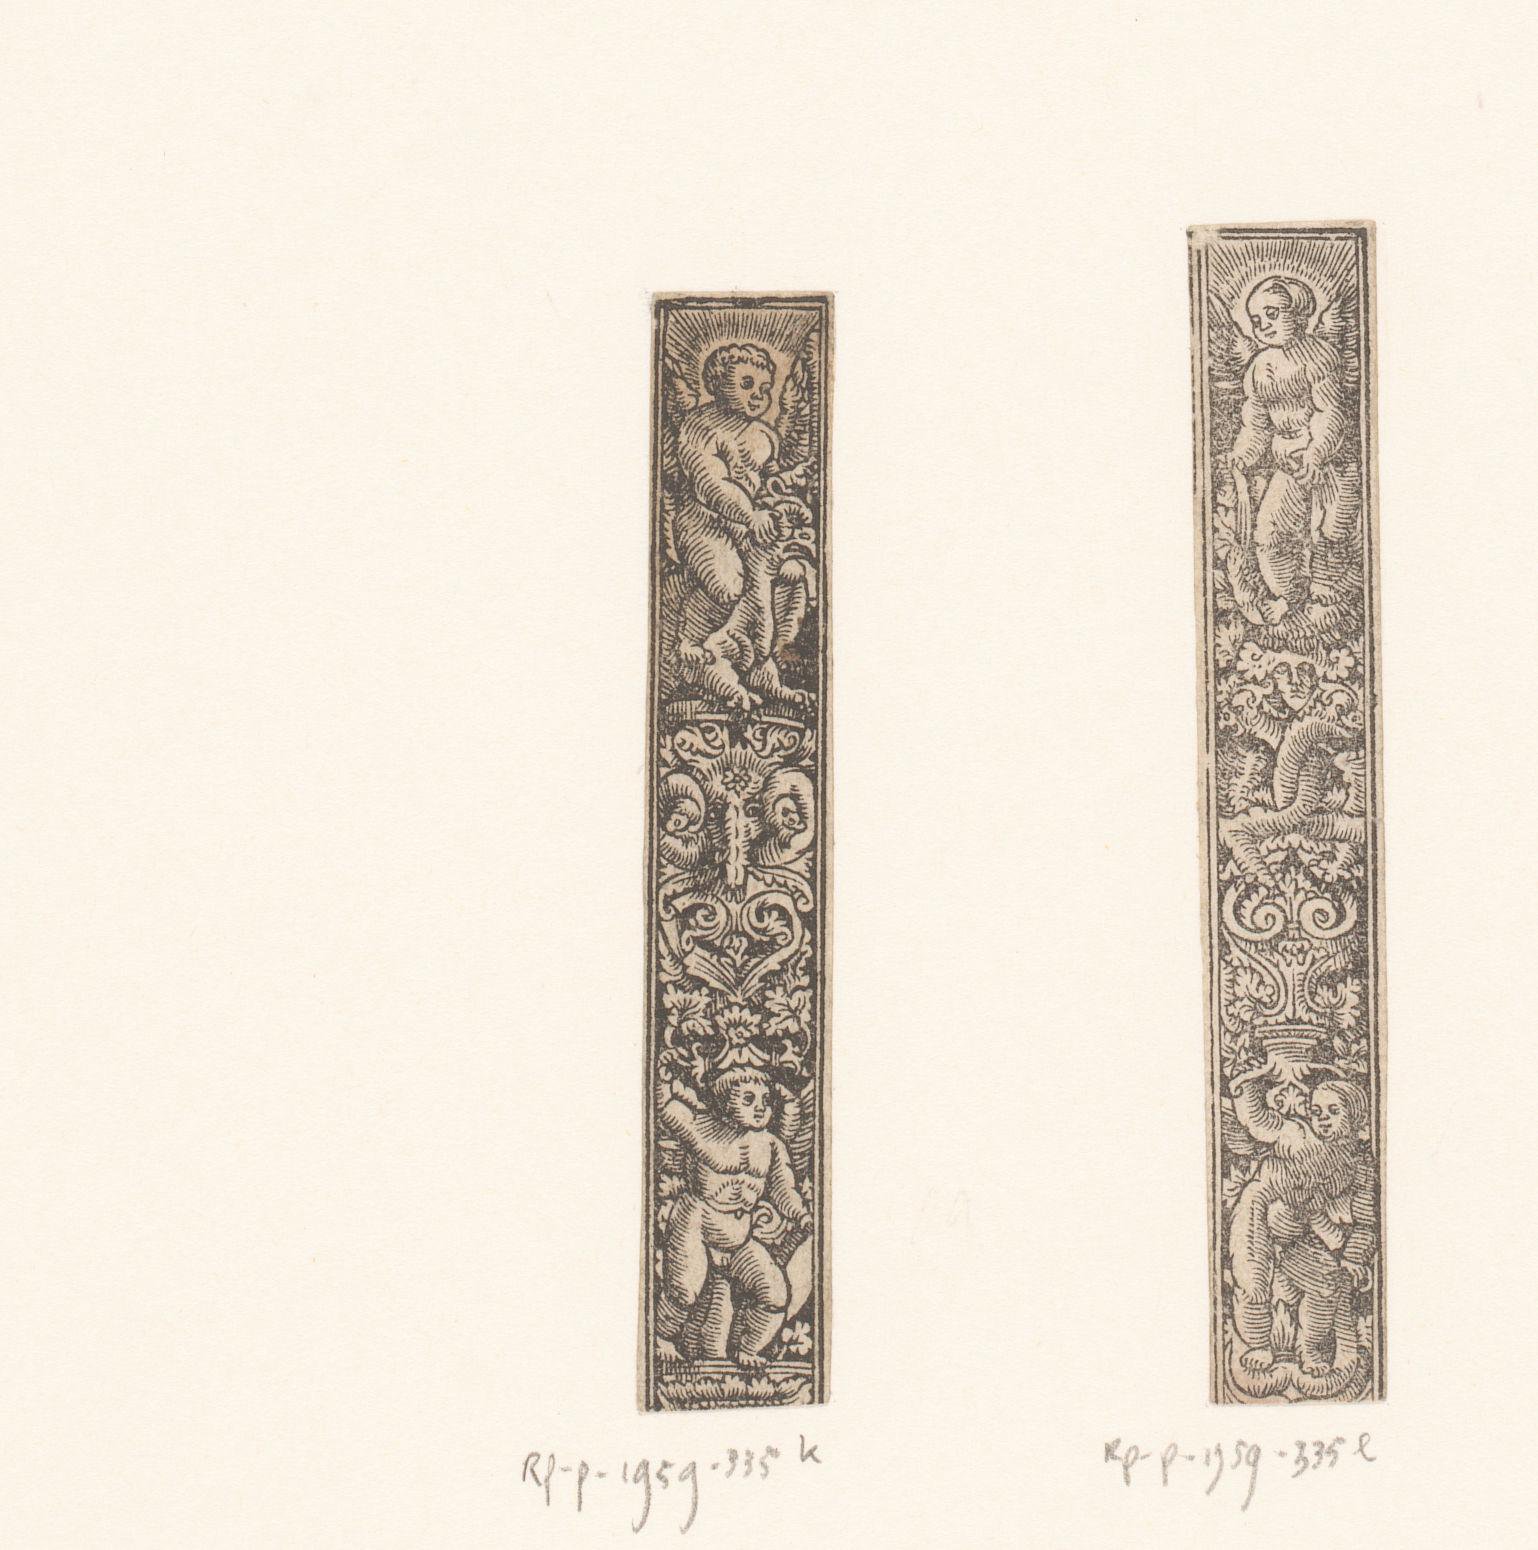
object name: print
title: Verticaal fries met twee putti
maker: Anonymous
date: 1500-1599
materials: paper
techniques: woodcut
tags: anthropomorphic ornament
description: Prent afkomstig uit een onbekende publicatie.